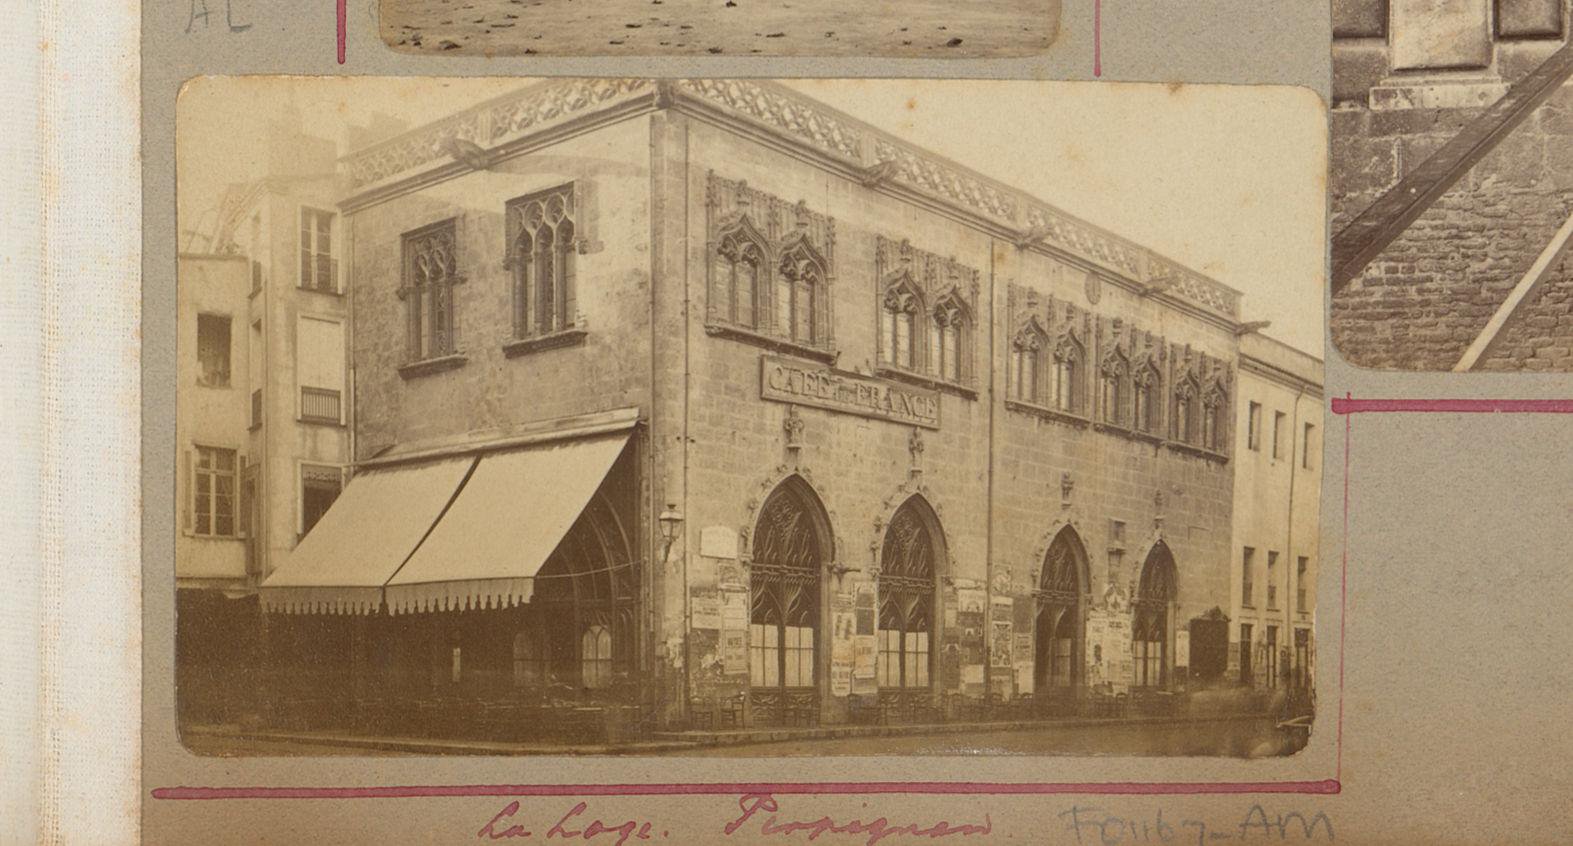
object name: album leaf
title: Café le France in Loge de Mer te Perpignan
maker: Anonymous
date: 1880-1910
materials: photographic support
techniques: albumen print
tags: inn, coffee-house, public house, etc., civic architecture; edifices; dwellings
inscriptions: annotation: ‘La Loge Perpignan’